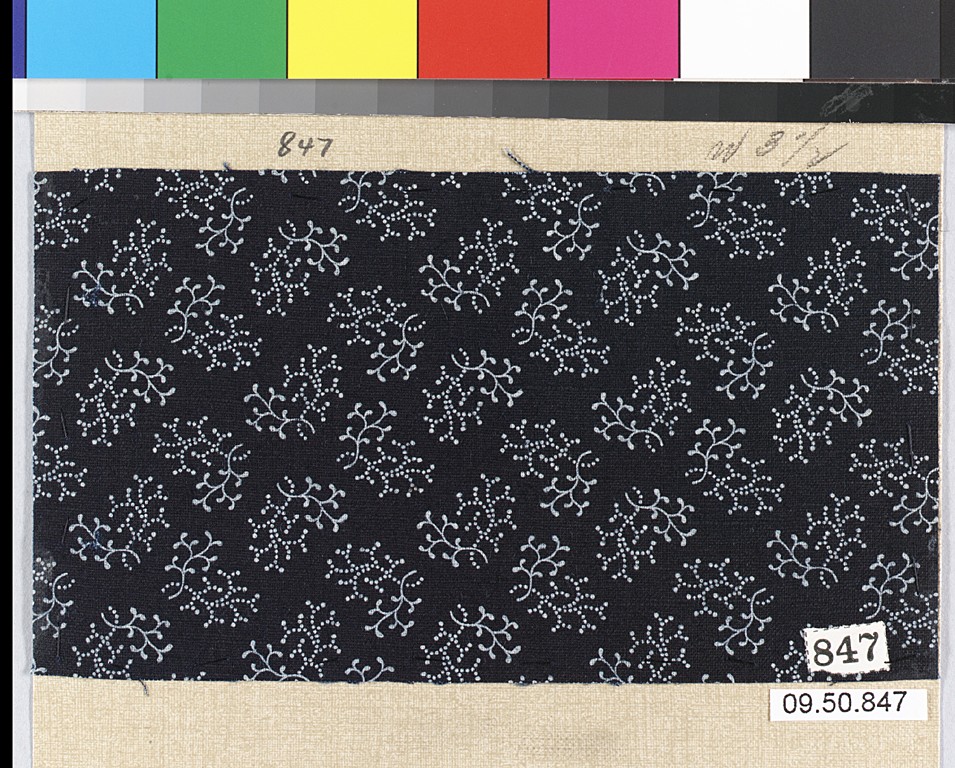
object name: piece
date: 1801-1900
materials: cotton